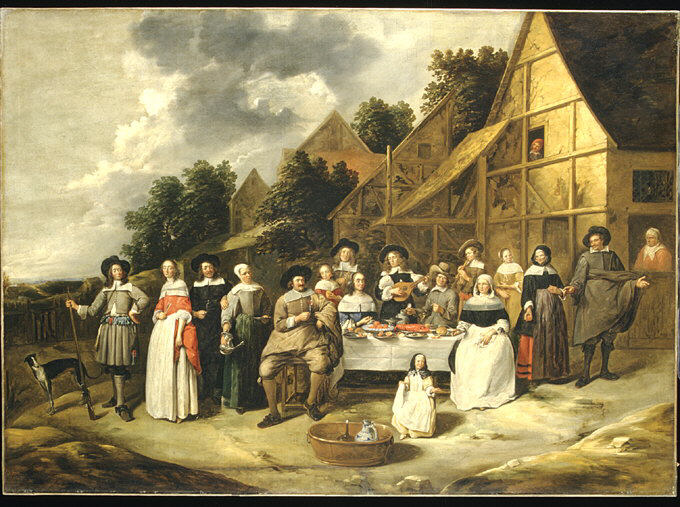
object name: painting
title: Group Portrait: A Wedding Celebration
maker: gillis van tilborgh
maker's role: artist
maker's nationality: flemish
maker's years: 1625-1678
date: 1645-1678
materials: canvas, oil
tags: girls,men,women,dogs,dining,musicians,weddings